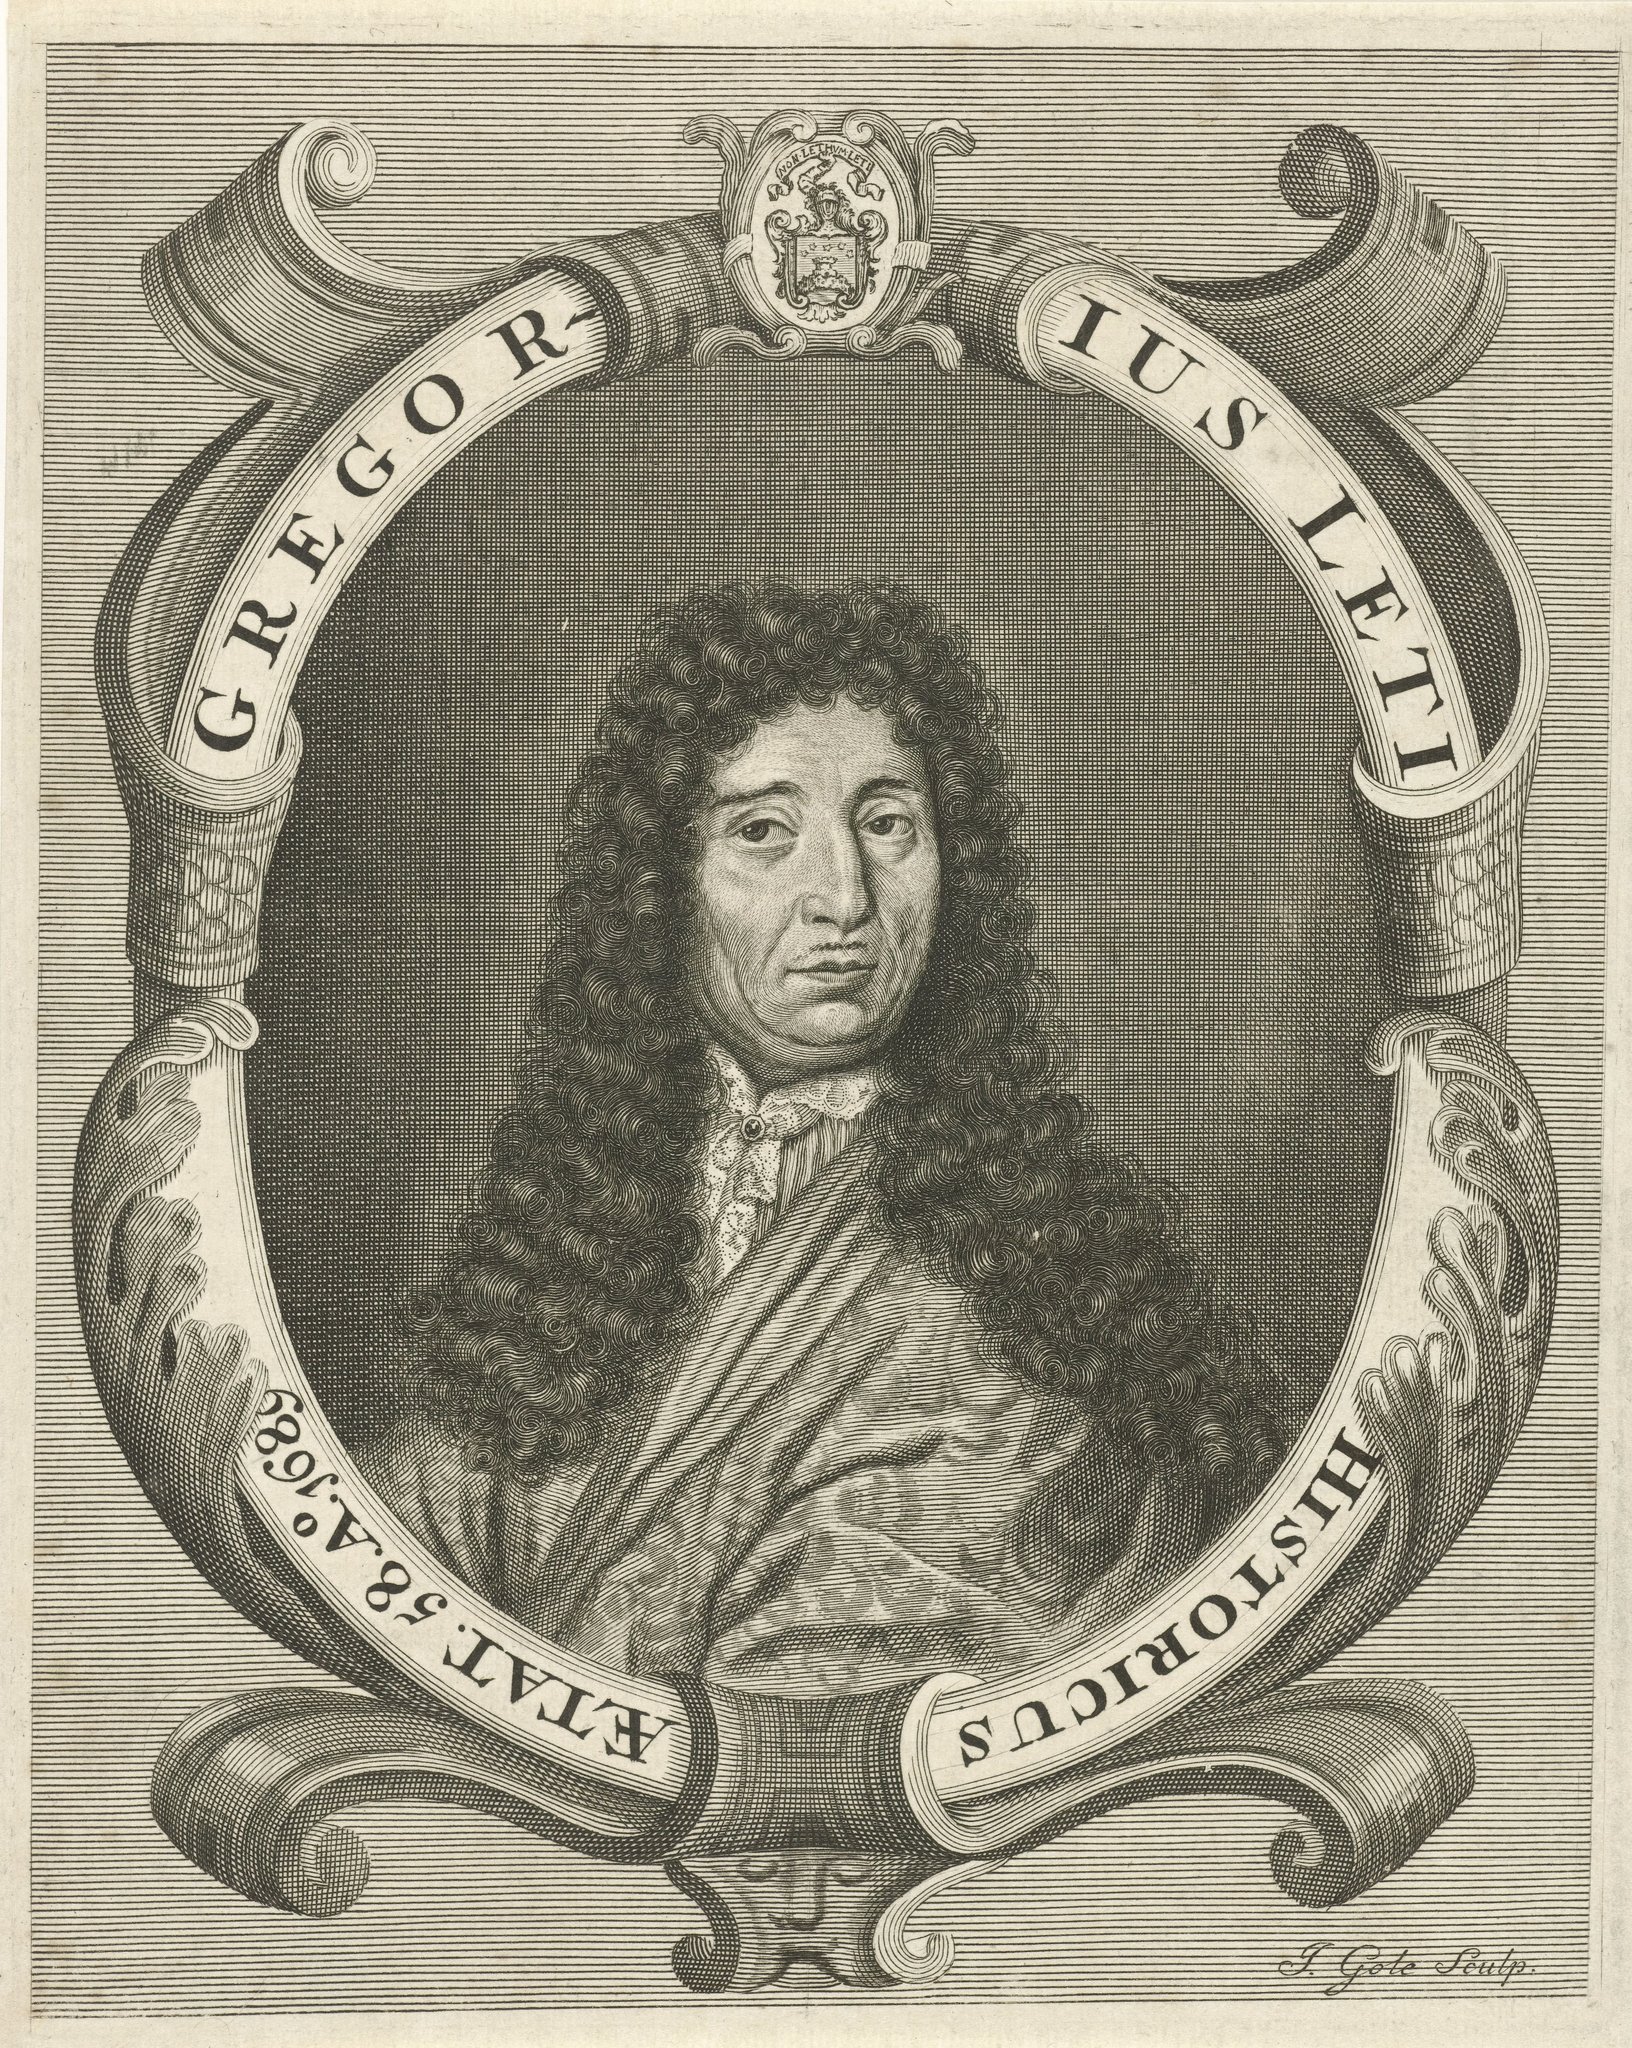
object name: print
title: Portret van Gregorio Leti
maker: jacob gole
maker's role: print maker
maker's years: 1660-1724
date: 1689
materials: paper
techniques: engraving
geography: amsterdam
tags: milaan, historicus, gregorio leti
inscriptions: collector's mark: Lugt 2228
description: Portret in ovale lijst van Gregorio Leti, een Italiaanse historicus. Ten halven lijve naar rechts.